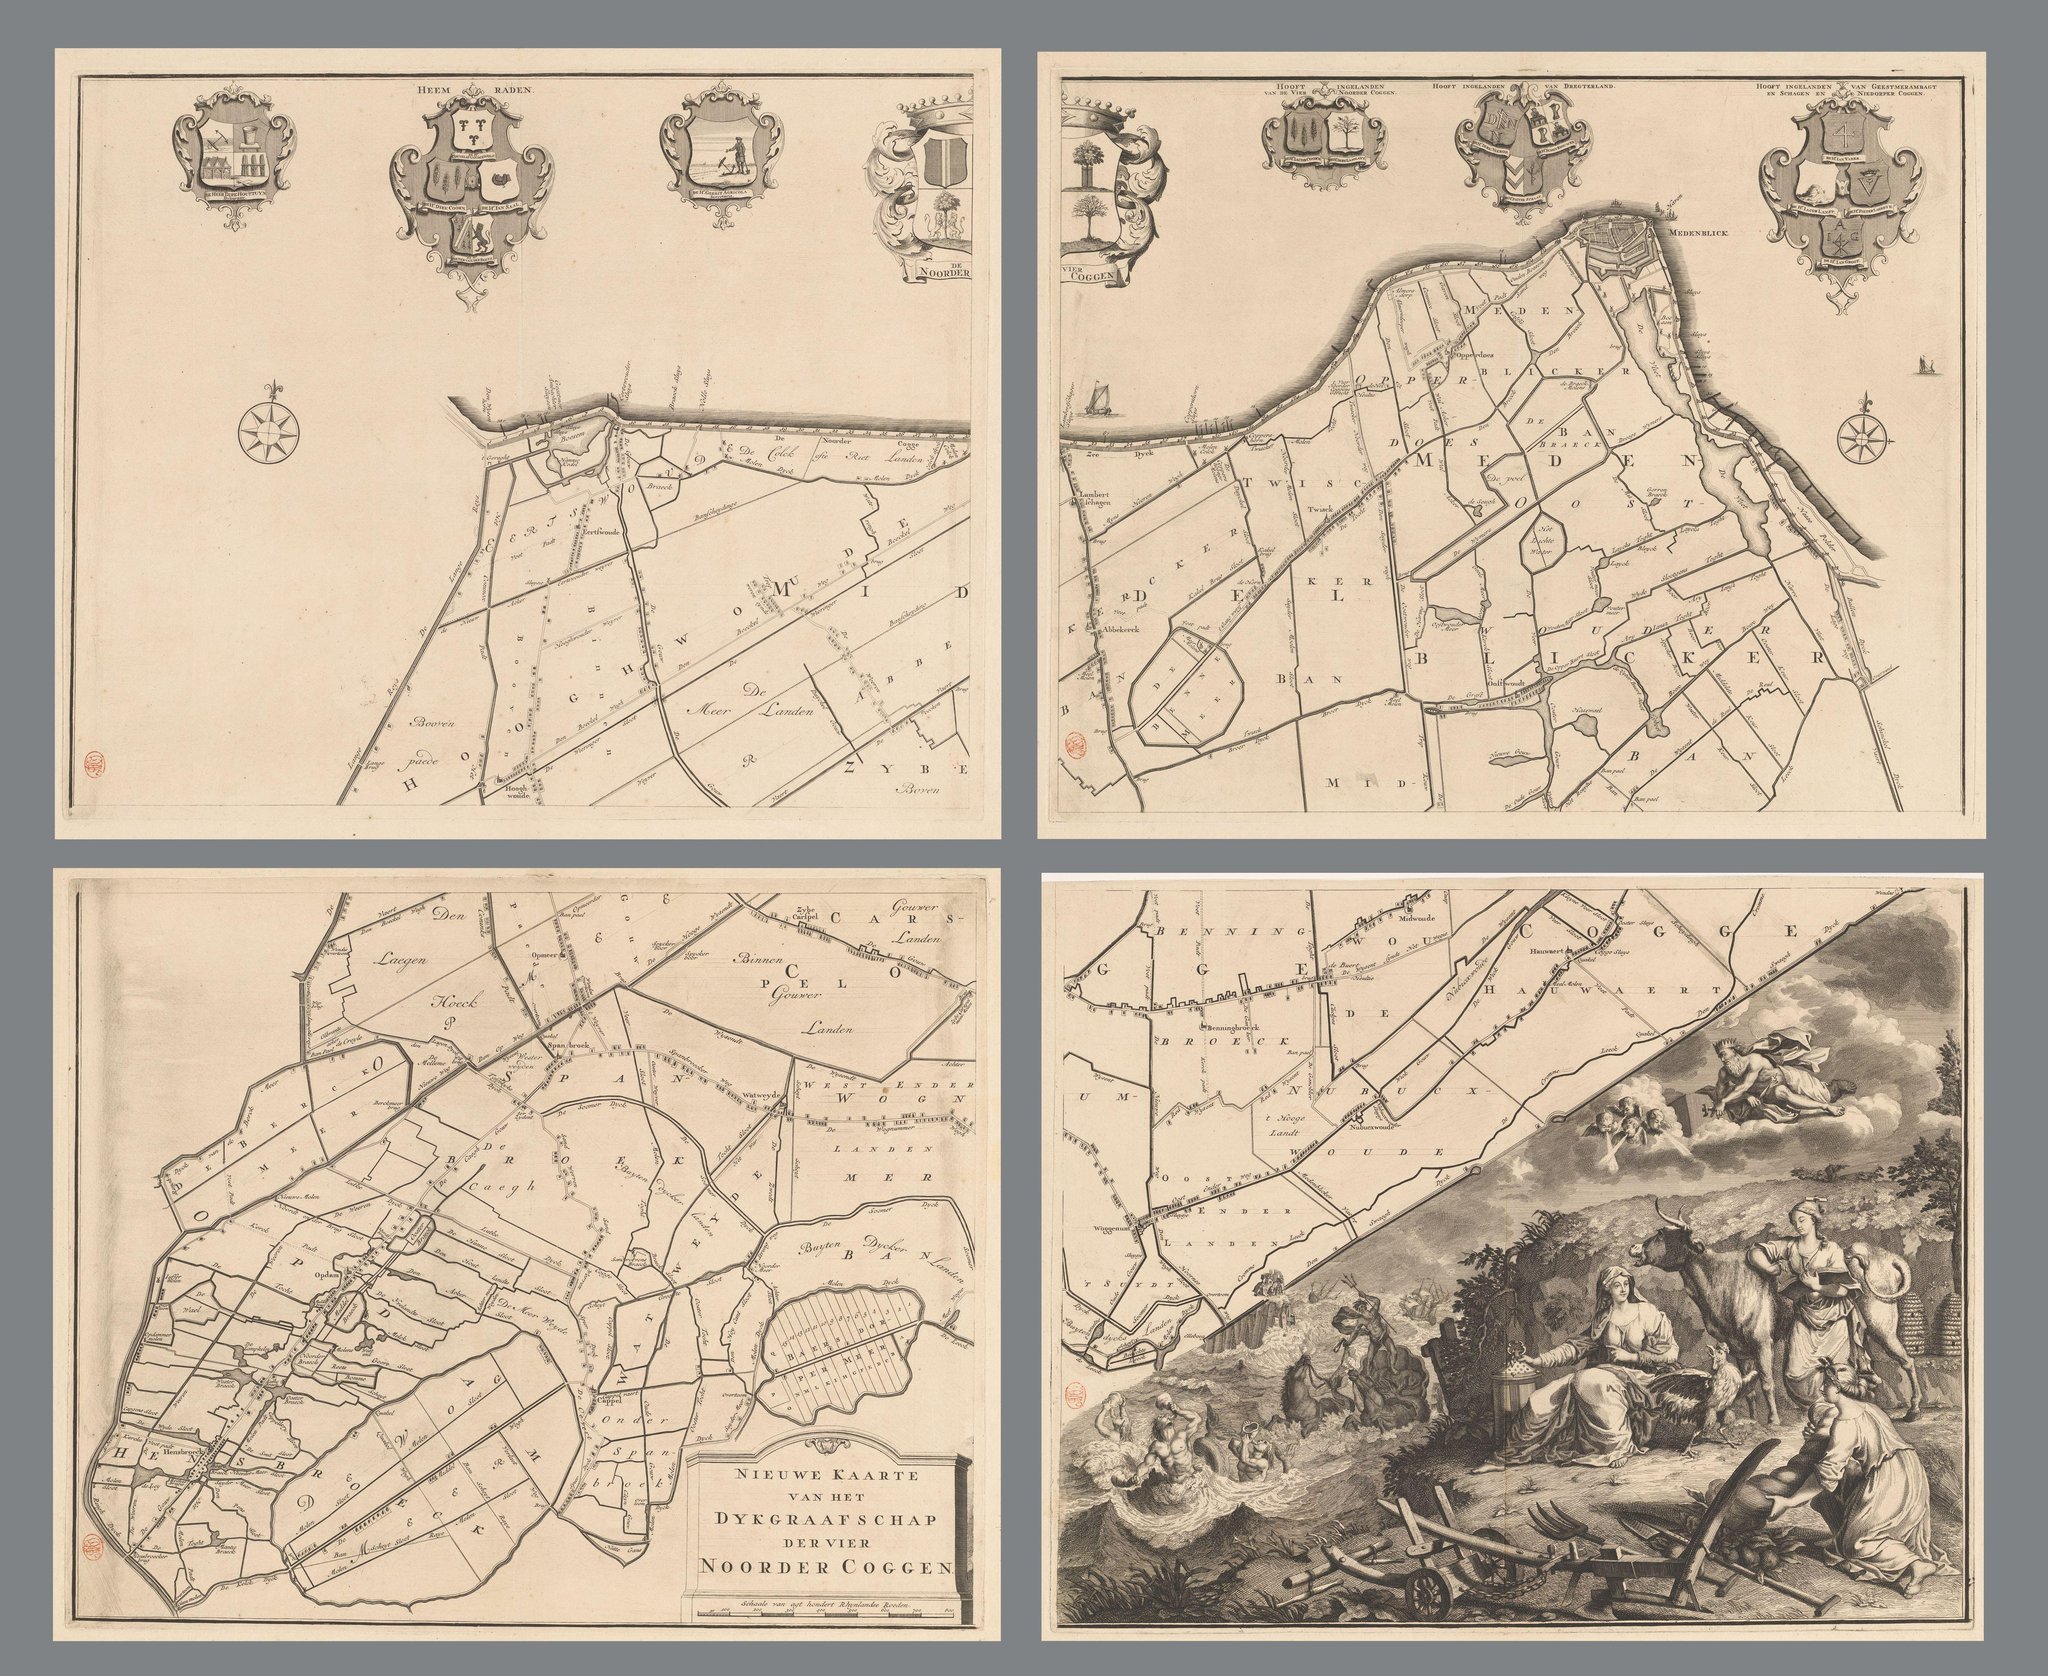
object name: map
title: Nieuwe kaarte van het dykgraafschap der Vier Noorder Coggen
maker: hendrik de leth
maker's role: draughtsman, print maker, publisher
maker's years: 1703-1766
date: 1731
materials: paper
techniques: engraving, etching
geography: amsterdam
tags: (story of) neptune (poseidon), coat of arms (as symbol of the state, etc.), triton(s), maps of separate countries or regions, polder, reclaimed land, (story of) aeolus, guardian of the winds; 'eolo' (ripa), armorial bearing, heraldry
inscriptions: collector's mark: Lugt 195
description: Dit object is omwille van een betere presentatie virtueel samengevoegd maar bestaat fysiek uit losse onderdelen. Datering gebaseerd op samenstelling van het bestuur van het dijkgraafschap. Vlak na het verschijnen van deze staat is een tweede staat uitgeven. Daarop staan dezelfde wapenschilden van de bestuursleden, maar zijn de naam van de prentmaker en de naam van de ontwerper toegevoegd en is de titel veranderd (Nieuwe kaarte van het Dykgraafschap van't Ooster Baljuwschap van West-Vriesland, genaamt Medenblick en de Vier Noorder Coggen). Mogelijk is de huidige staat, waarvan tot dusver geen andere exemplaren bekend zijn, dus een proefdruk. De Bibliothèque nationale de France bezit een exemplaar van de tweede staat: http://gallica.bnf.fr/ark:/12148/btv1b53039237c.